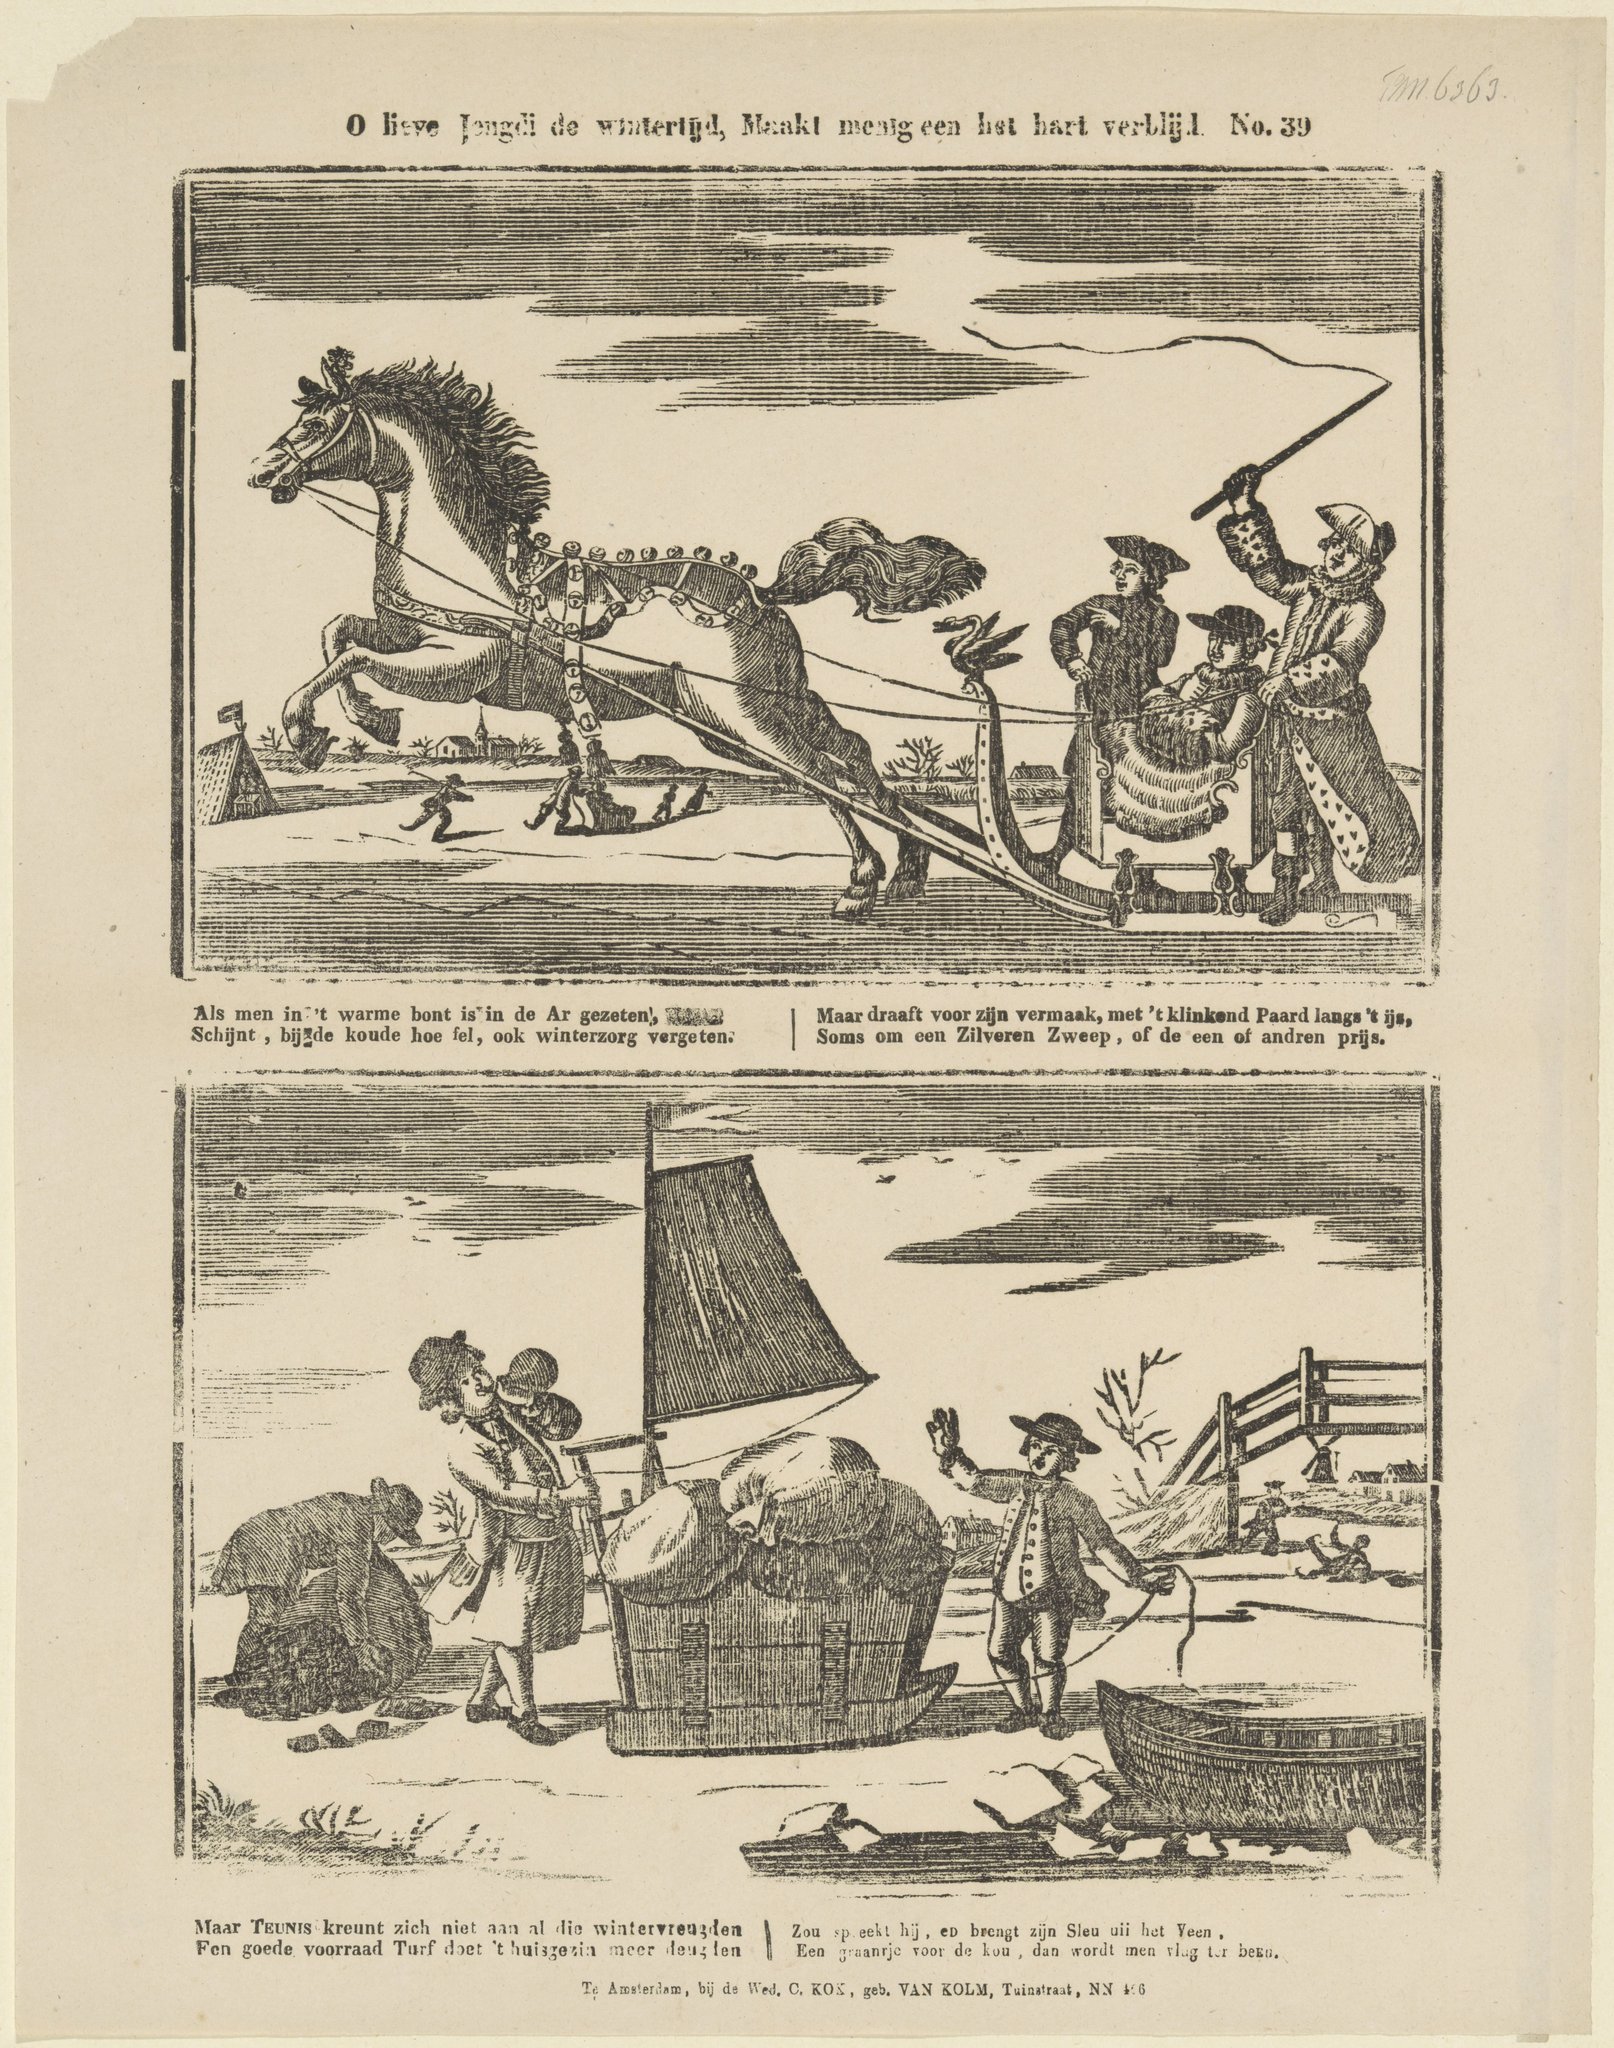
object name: print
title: O jonge jeugd! de wintertyd, maakt menig een het hart verblyd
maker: weduwe c. kok geboren van kolm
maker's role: printer, publisher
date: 1842-1866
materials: paper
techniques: letterpress printing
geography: amsterdam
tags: horse-sleigh, sledge, sleigh (winter sports)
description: Blad met 2 wintertaferelen. Boven: mensen op een slee die wordt voortgetrokken door een paard. Onder: jongens die turf bezorgen. Onder elke afbeelding een vierregelig vers. Genummerd rechtsboven: No. 39.